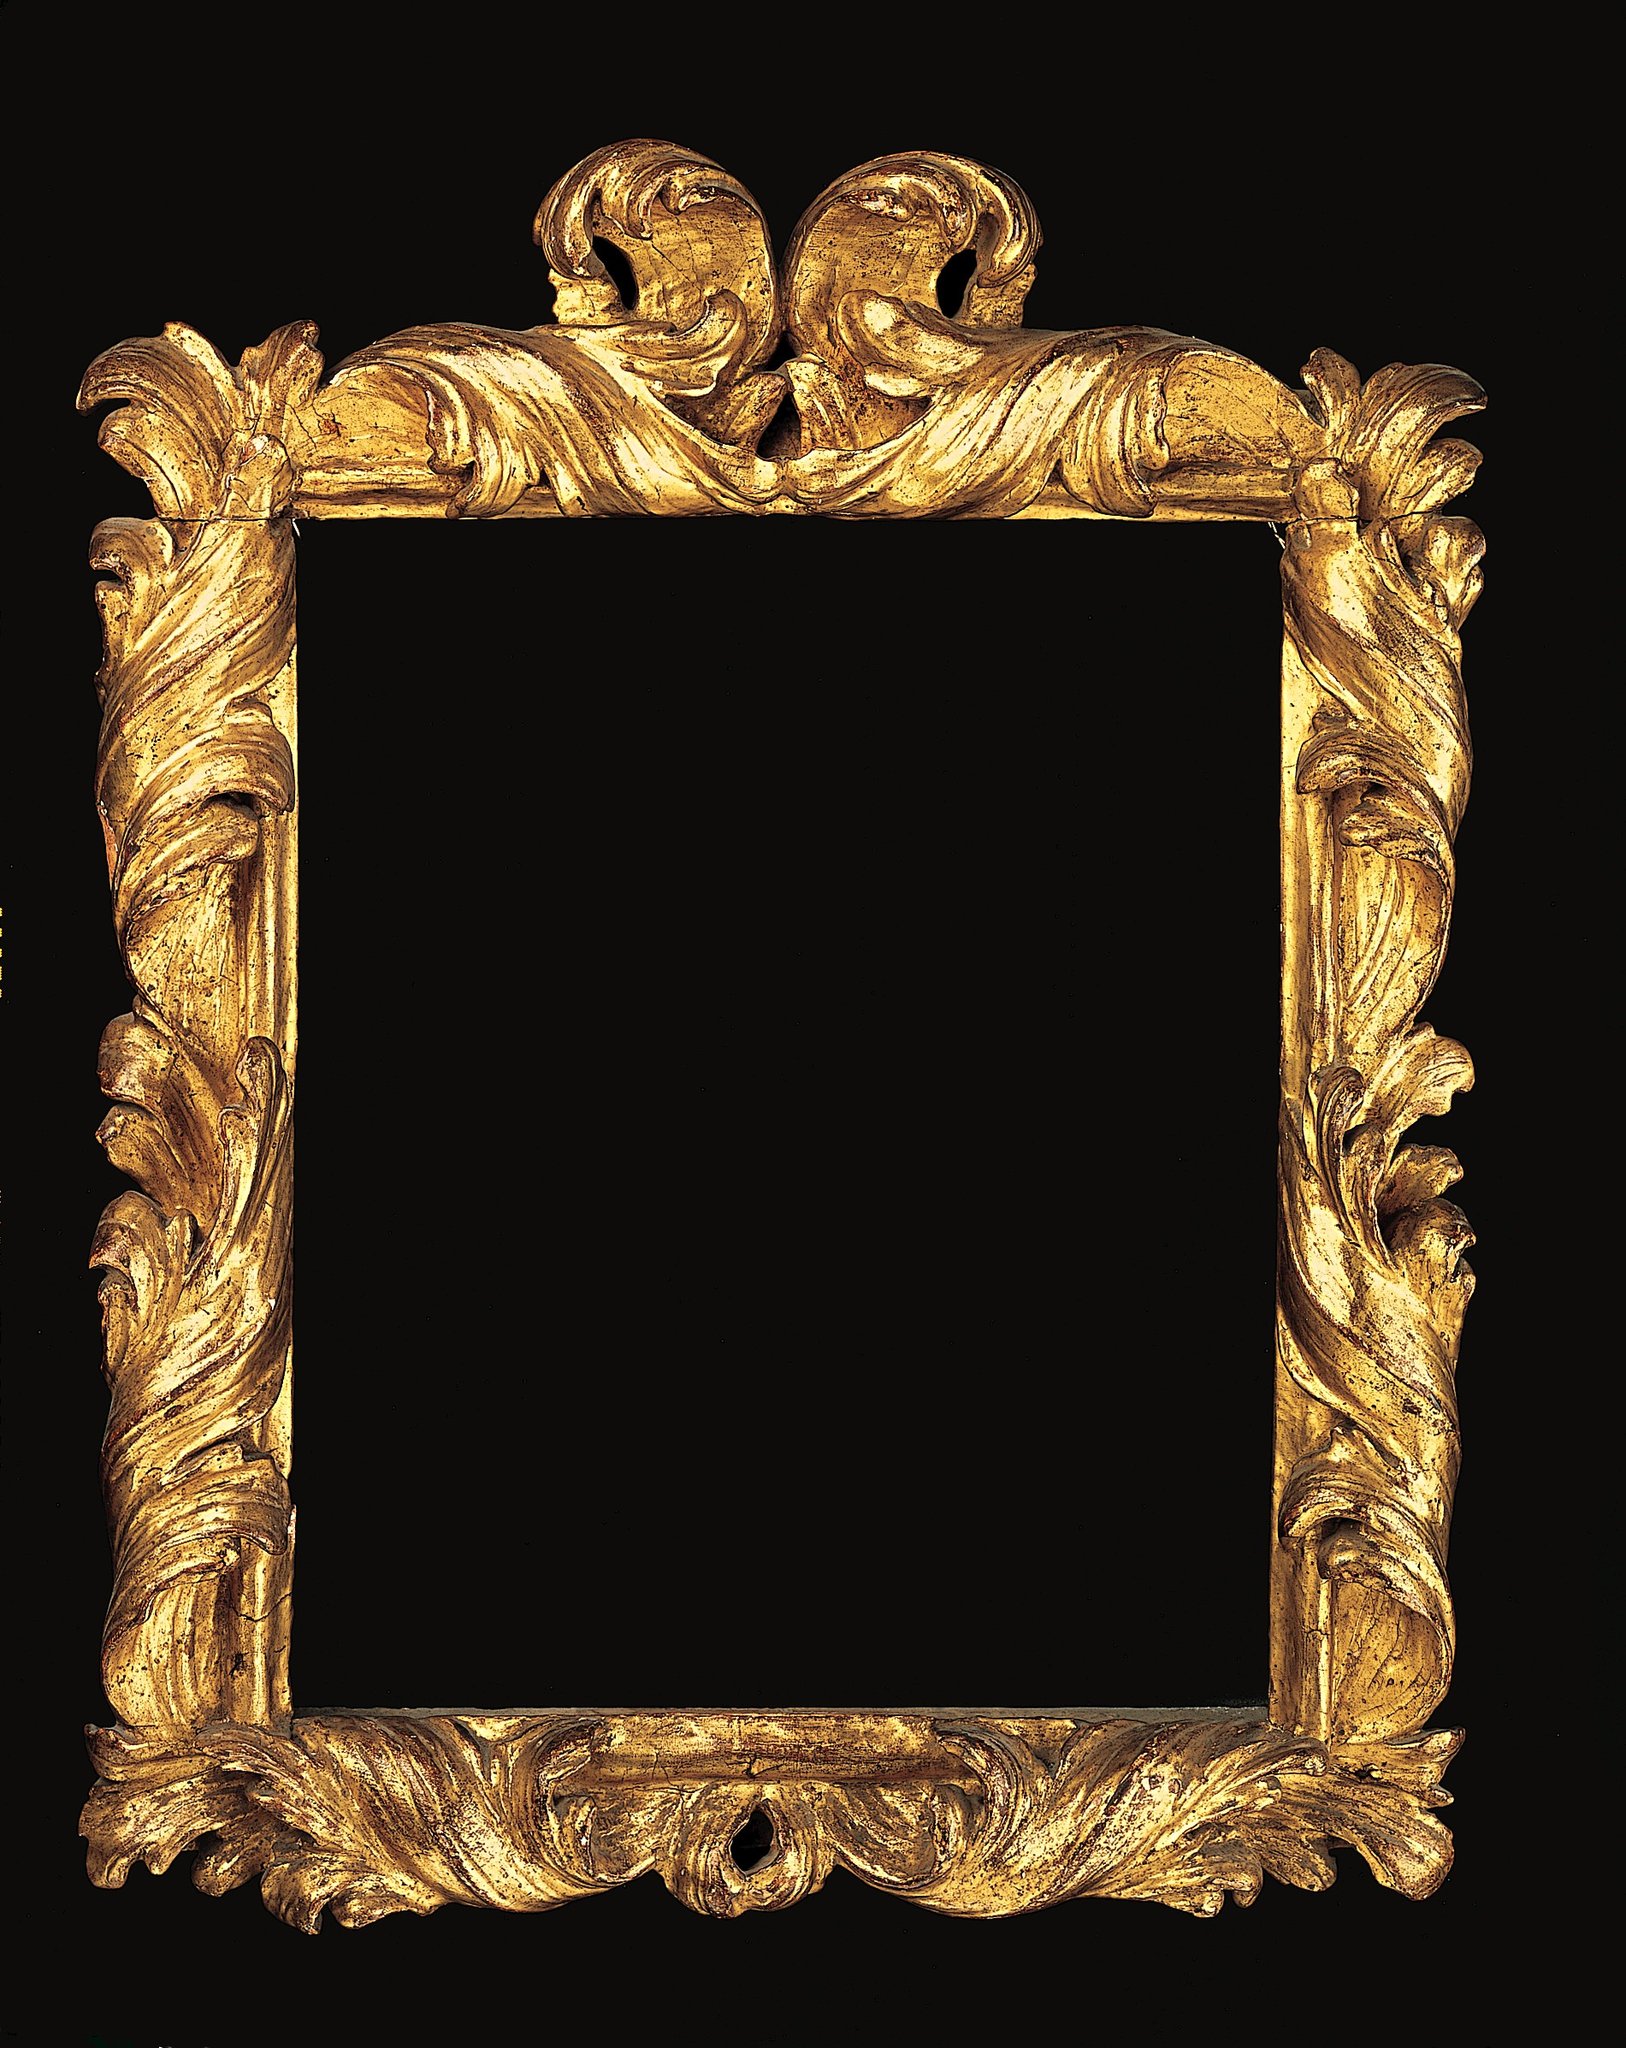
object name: frame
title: Astragal frame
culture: italian, veneto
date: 1701-1733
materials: wood